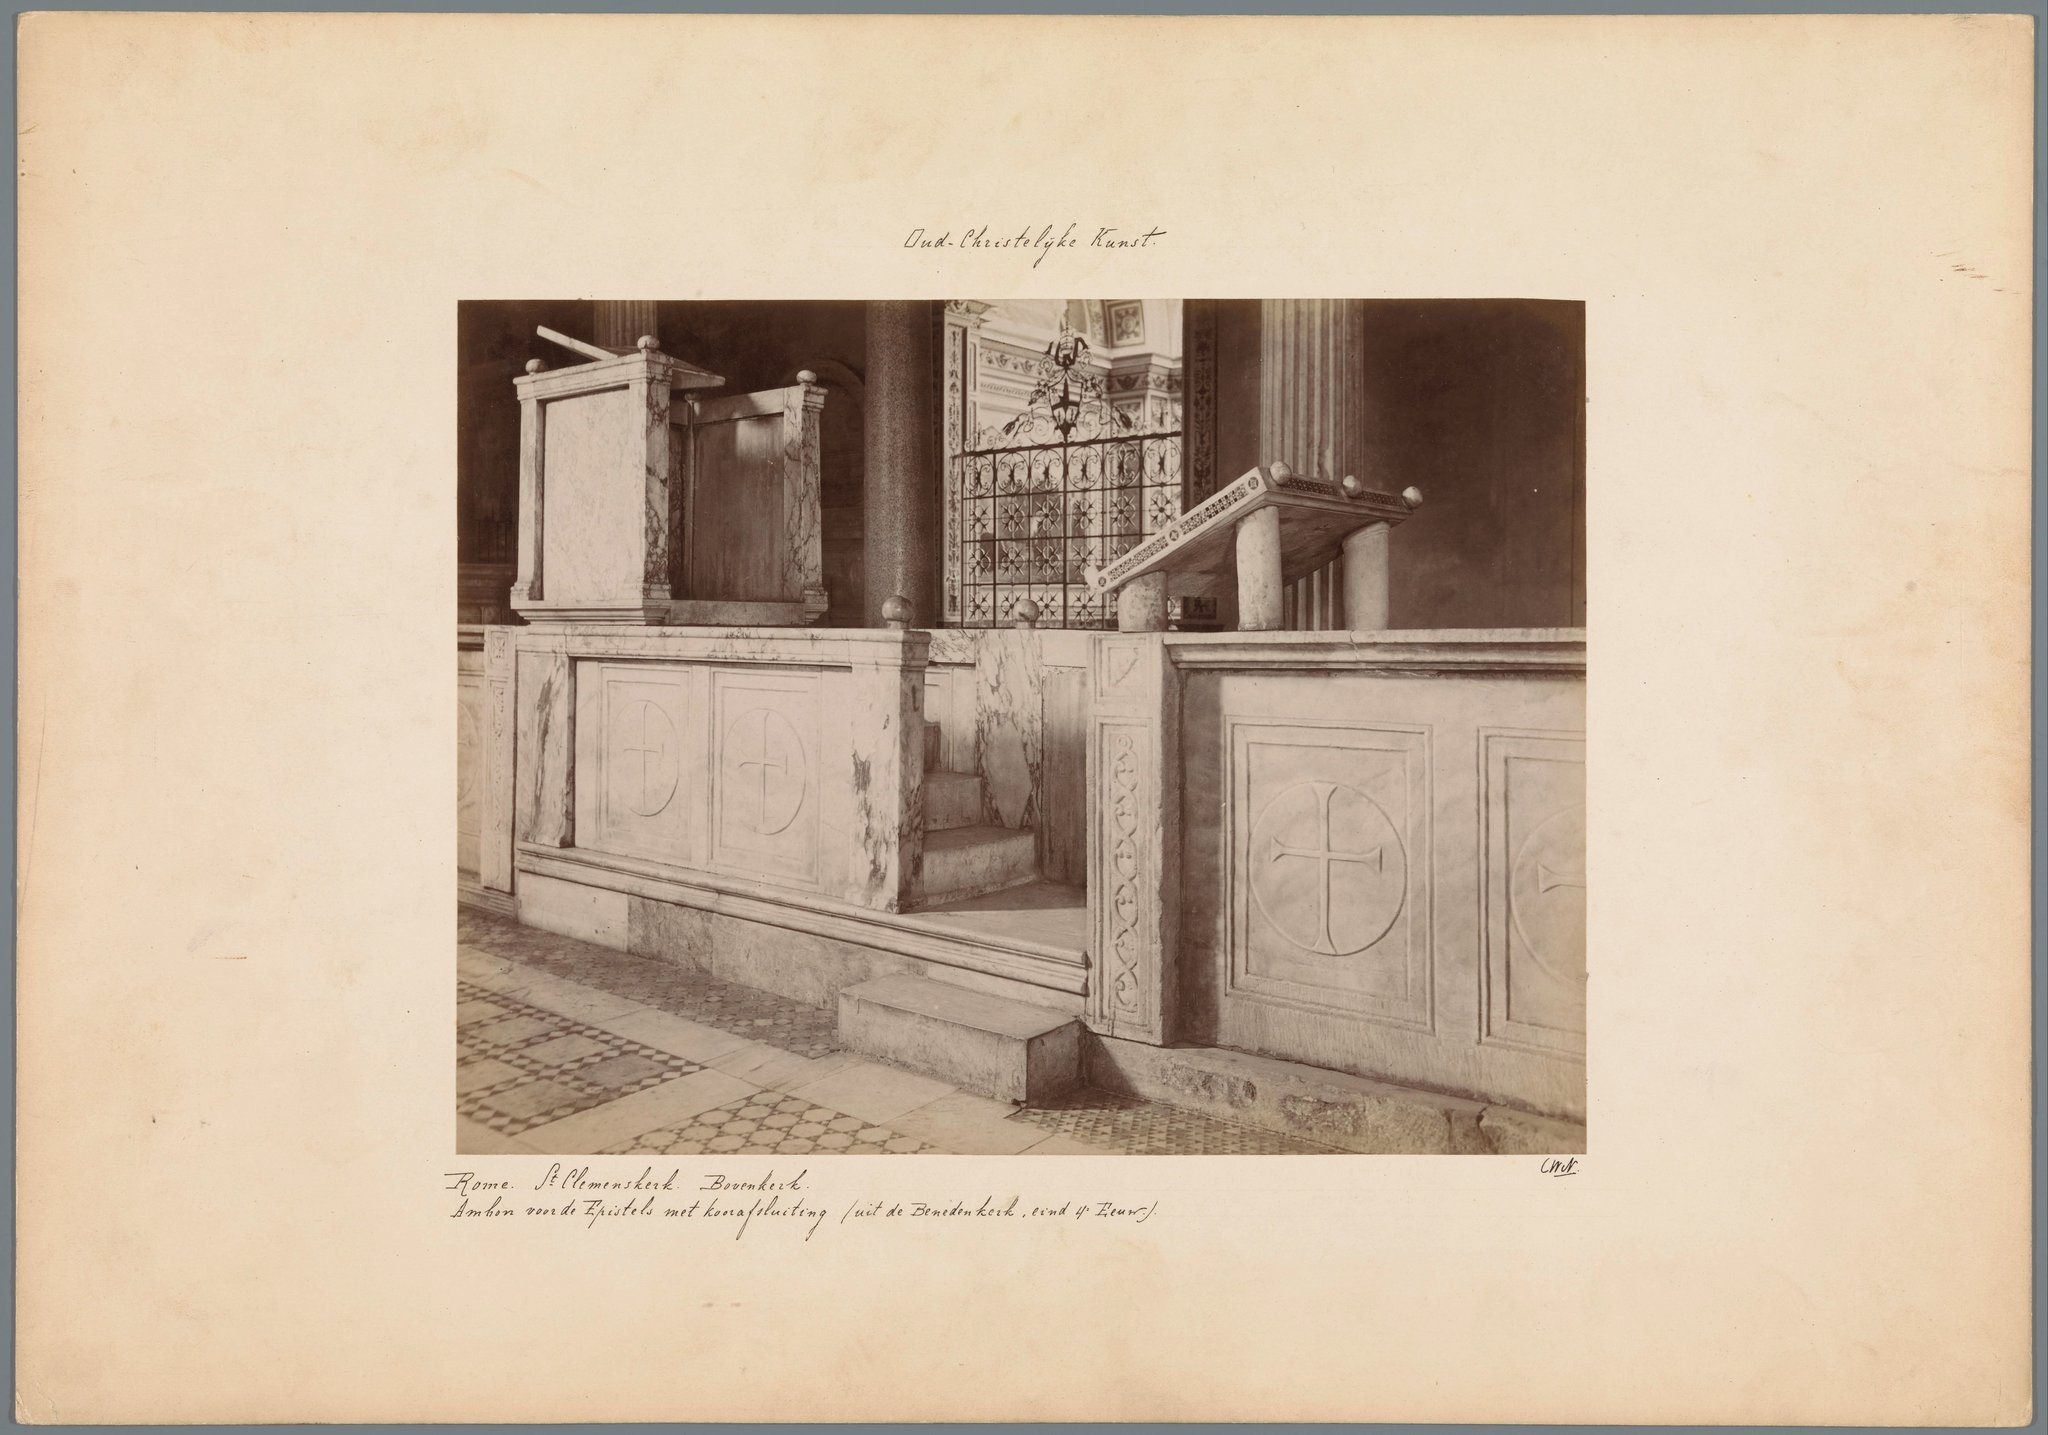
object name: photograph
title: Preekstoel en deel van een koorhek in de San Clemente te Rome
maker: Anonymous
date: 1875-1900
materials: cardboard, photographic support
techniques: albumen print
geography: san clemente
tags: rood-screen, choir-screen; iconostasis, interior of church, pulpit, ambo, chancel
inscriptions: collector's mark: ‘INSTITUUT VOOR KUNST- NIJVERHEIDSONDERWIJS GABRIËL METSUSTRAAT No. 16. AMSTERDAM’, inscription: ‘Oud-Christelijke Kunst. Rome (...) Ambon voor de Epistels met koorafsluiting (uit de Benedenkerk, eind 4e Eeuw.).’, collector's mark: ‘KUNSTNIJVERHEIDSCHOOL QUELLINUS AMSTERDAM FRANS HALSSTRAAT 14.’, inscription: ‘CWN.’